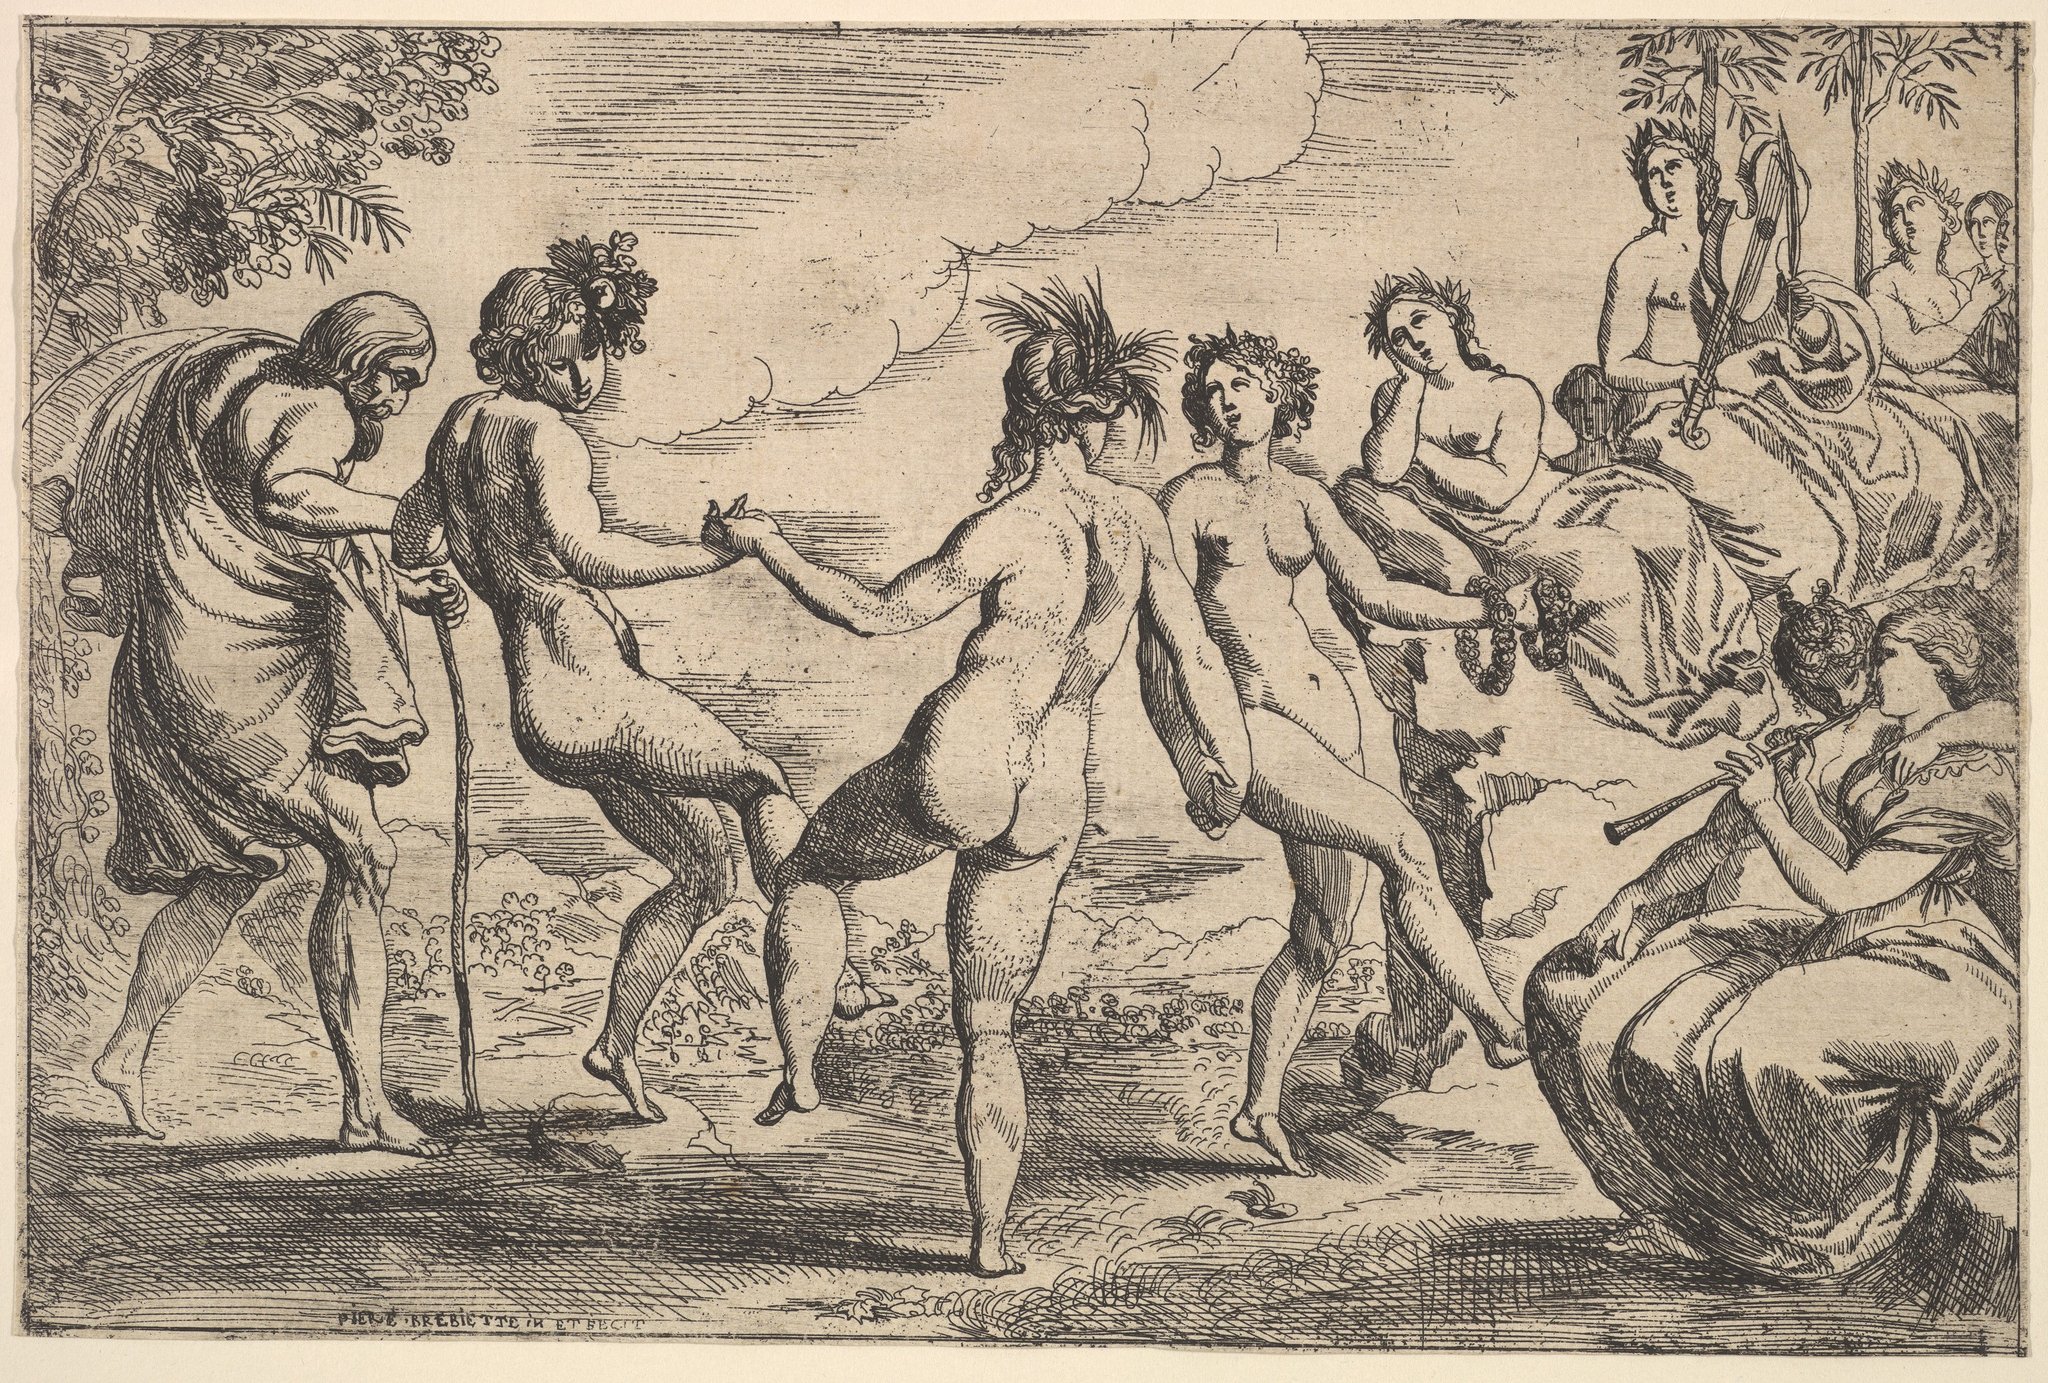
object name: print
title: Orpheus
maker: pierre brebiette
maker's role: artist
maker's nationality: french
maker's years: 1598-1642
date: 1610-1642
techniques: etching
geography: france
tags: musical instruments,male nudes,female nudes,music,orpheus